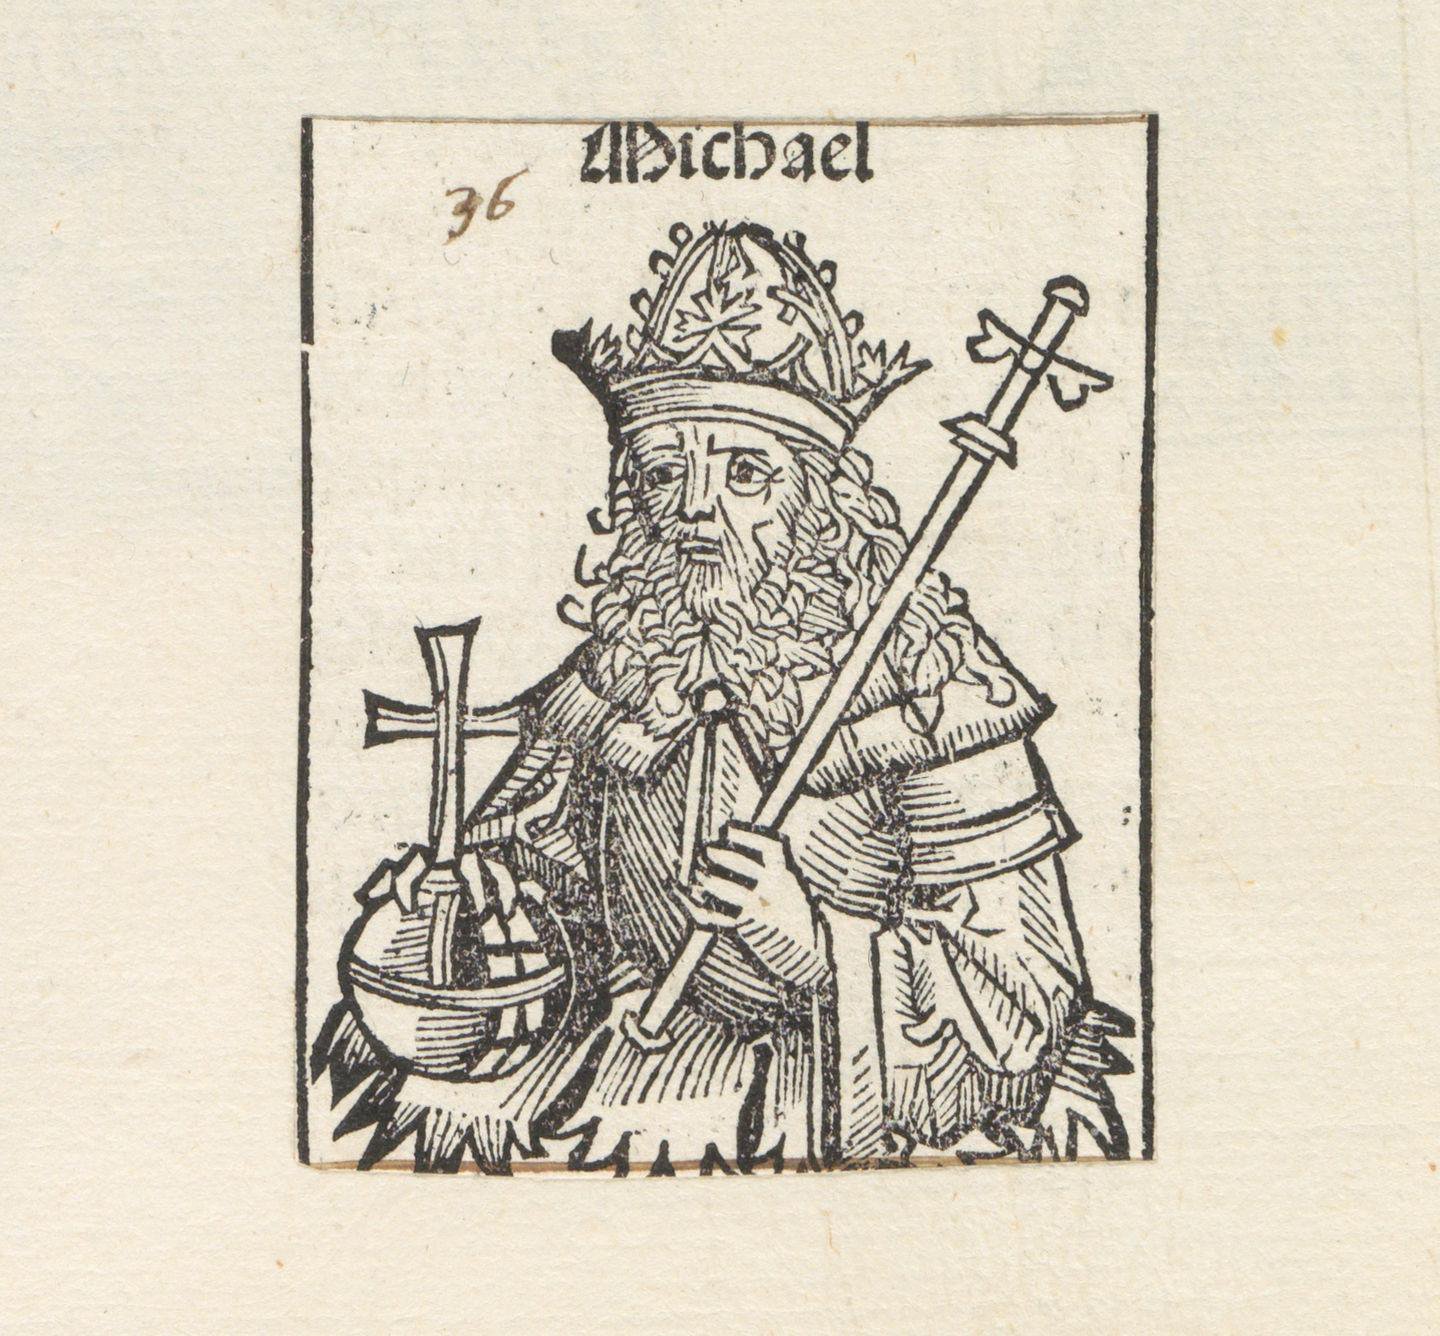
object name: book illustration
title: Keizer Michaël I Rangabe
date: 1493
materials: paper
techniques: letterpress printing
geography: nuremberg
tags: emperor, king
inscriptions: inscription: ‘36’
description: Een bloemkelk met een koning, naar links gekeerd. In zijn handen heeft hij een rijksappel en een scepter. De voorstelling is onderdeel van de opeenvolging keizers in de Liber Chronicarum. De tekst identificeert de man als keizer Michaël I Rangabe. De prent maakt deel uit van een album.